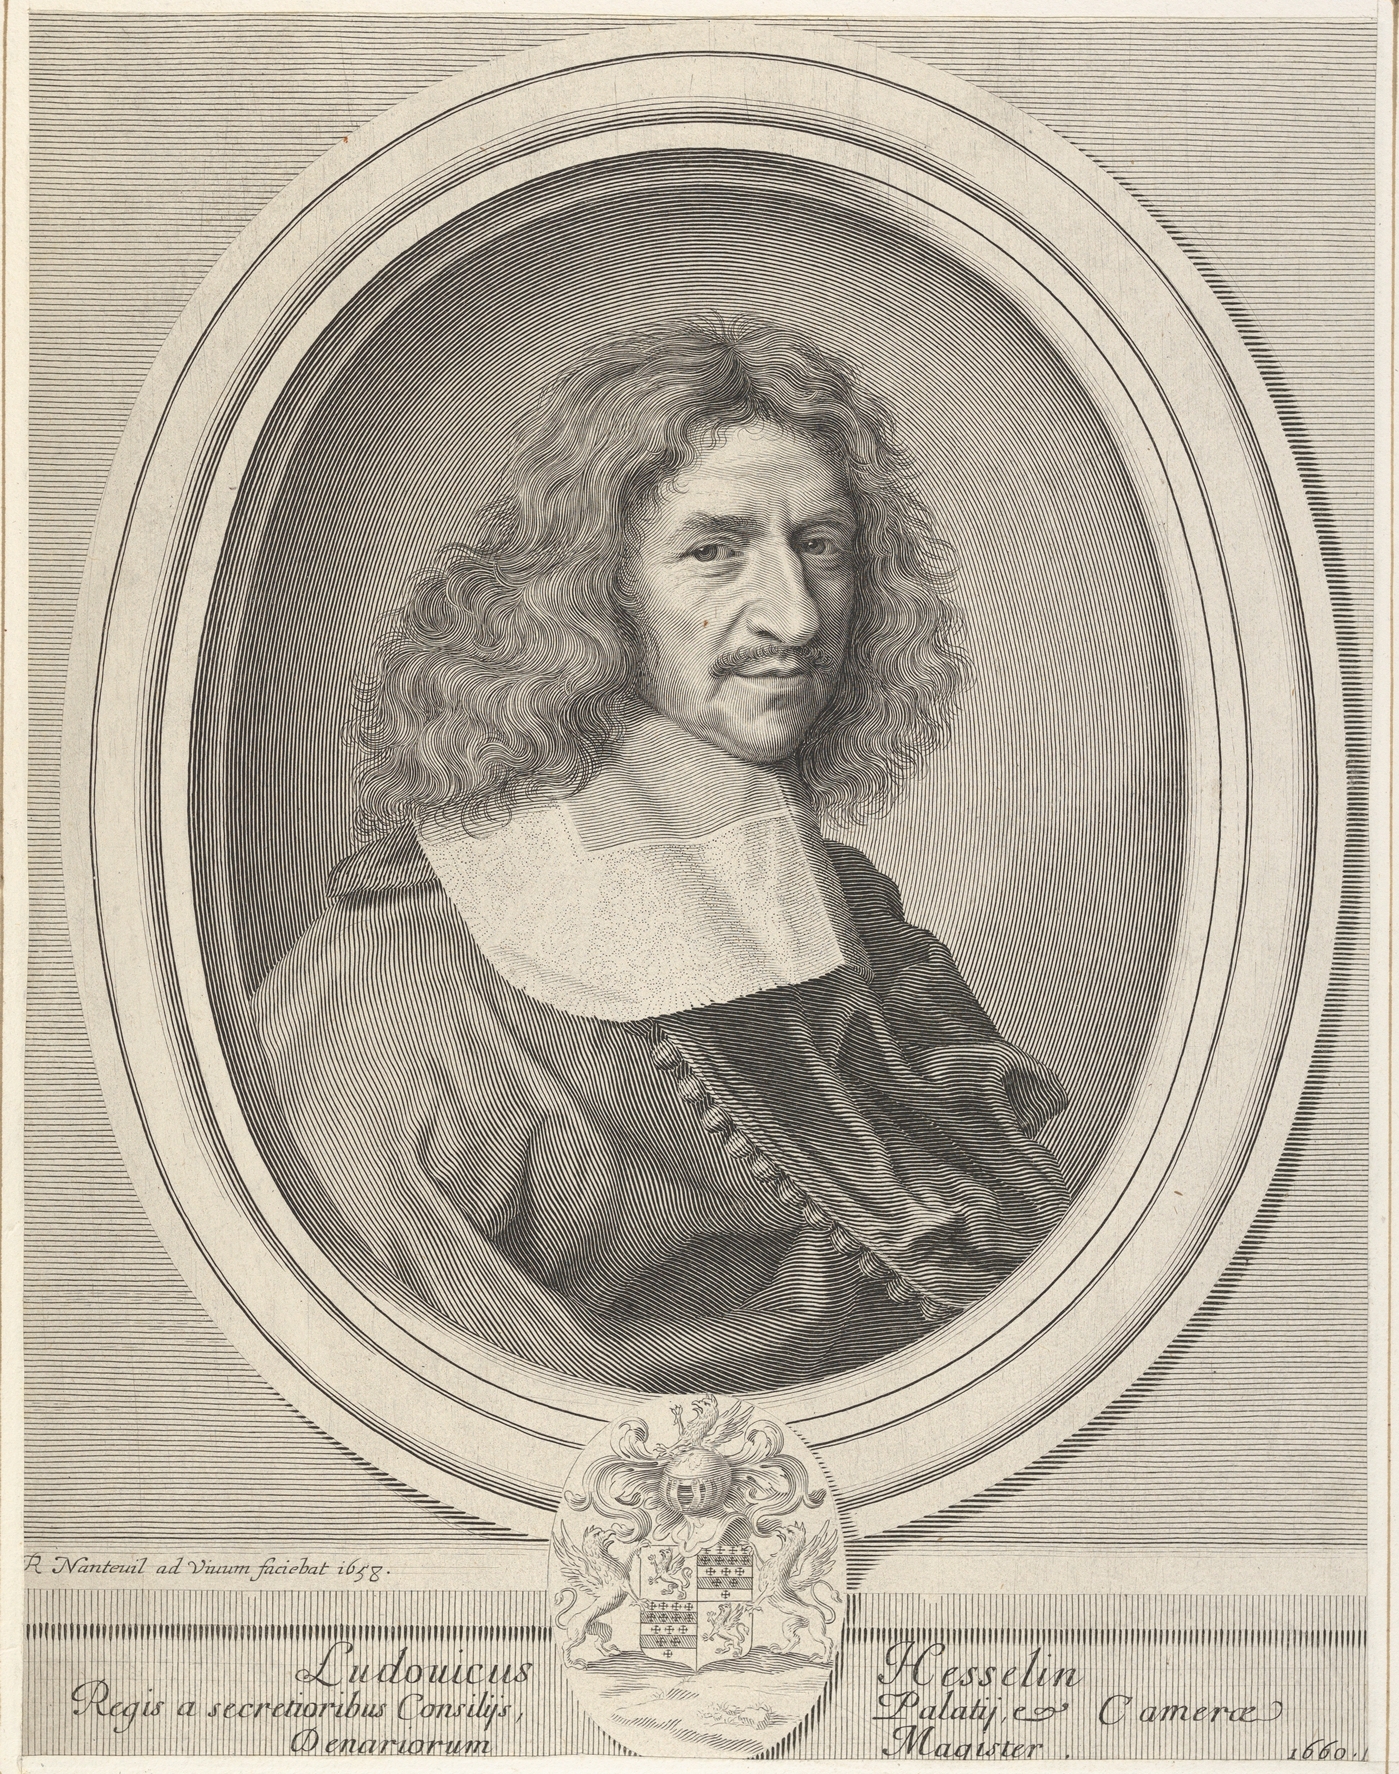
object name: print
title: Louis Hesselin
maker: robert nanteuil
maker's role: artist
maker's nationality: french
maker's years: 1623-1678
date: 1660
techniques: engraving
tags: men,portraits,coat of arms